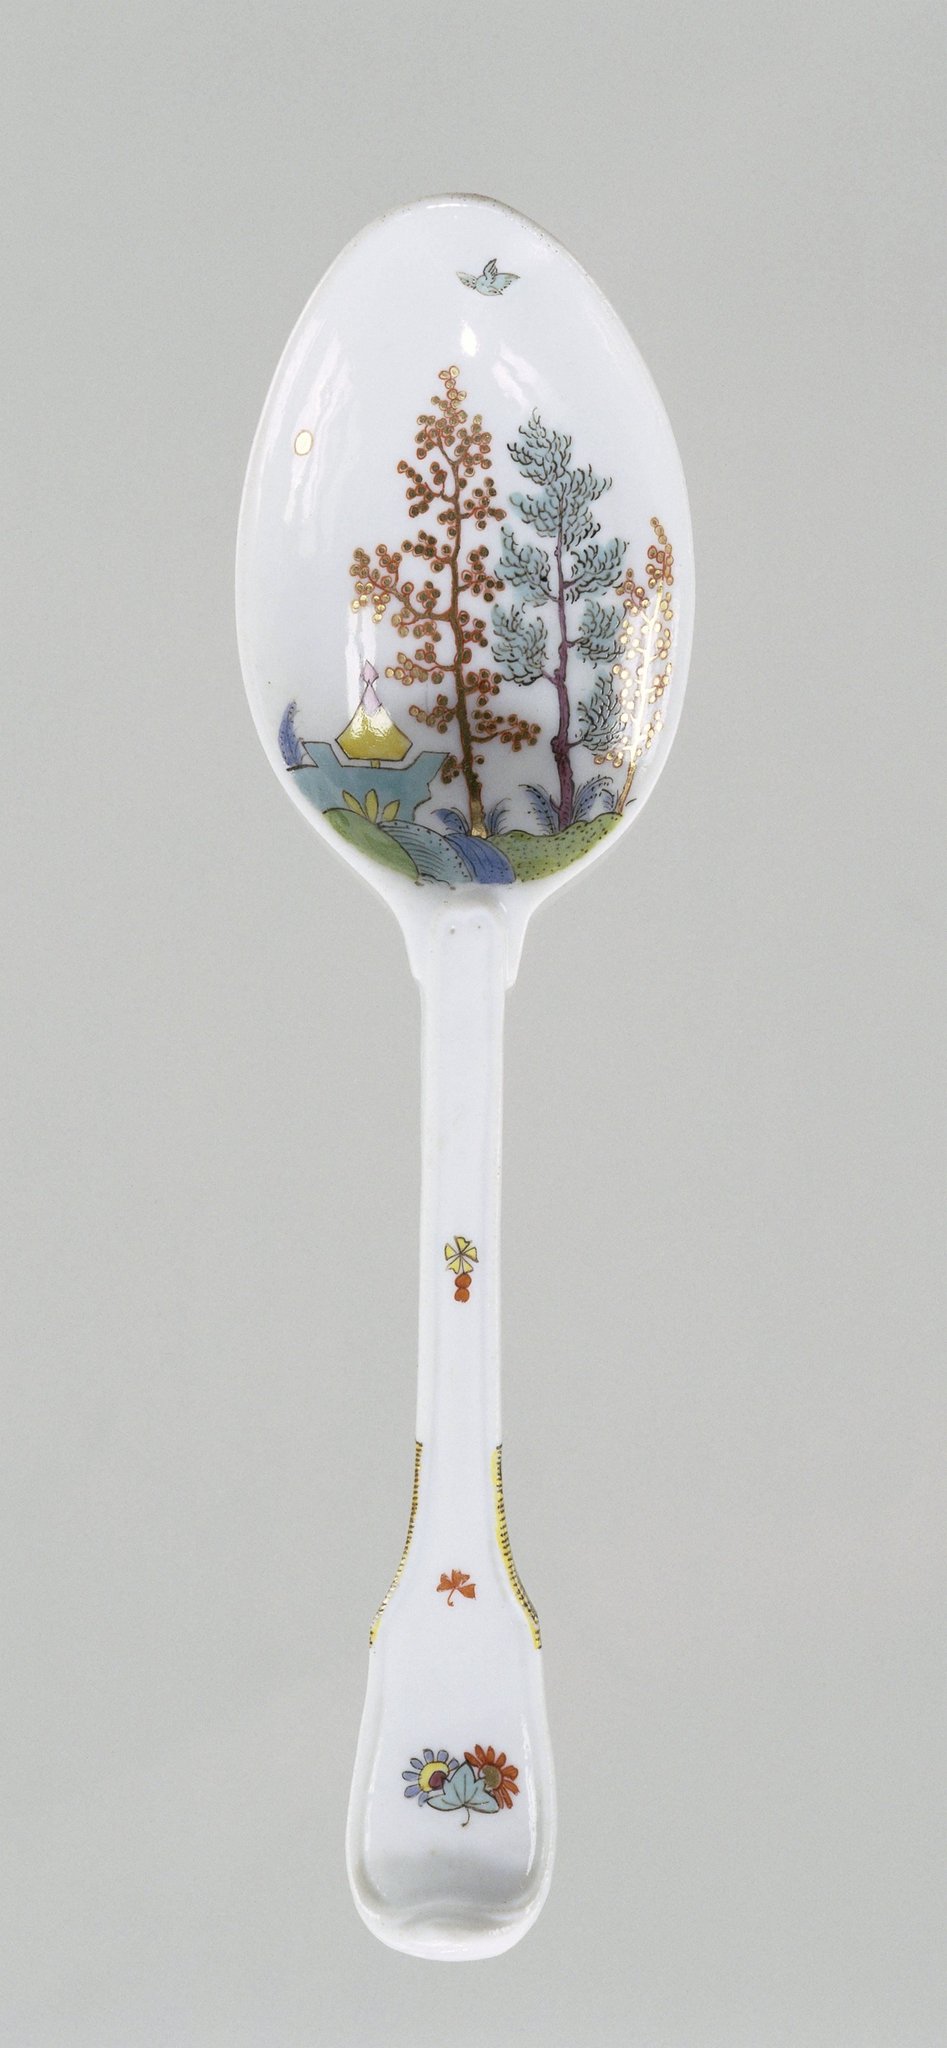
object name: spoon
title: Lepel, veelkleurig beschilderd met een Kakiemon-decor en het wapen van Johann Christian graaf von Hennicke (1681-1752)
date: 1735-1740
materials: porcelain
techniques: painted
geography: meissen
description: Spoon from the service of Count Johann Christian von Hennicke. Porcelain, Meissen, c. 1735.